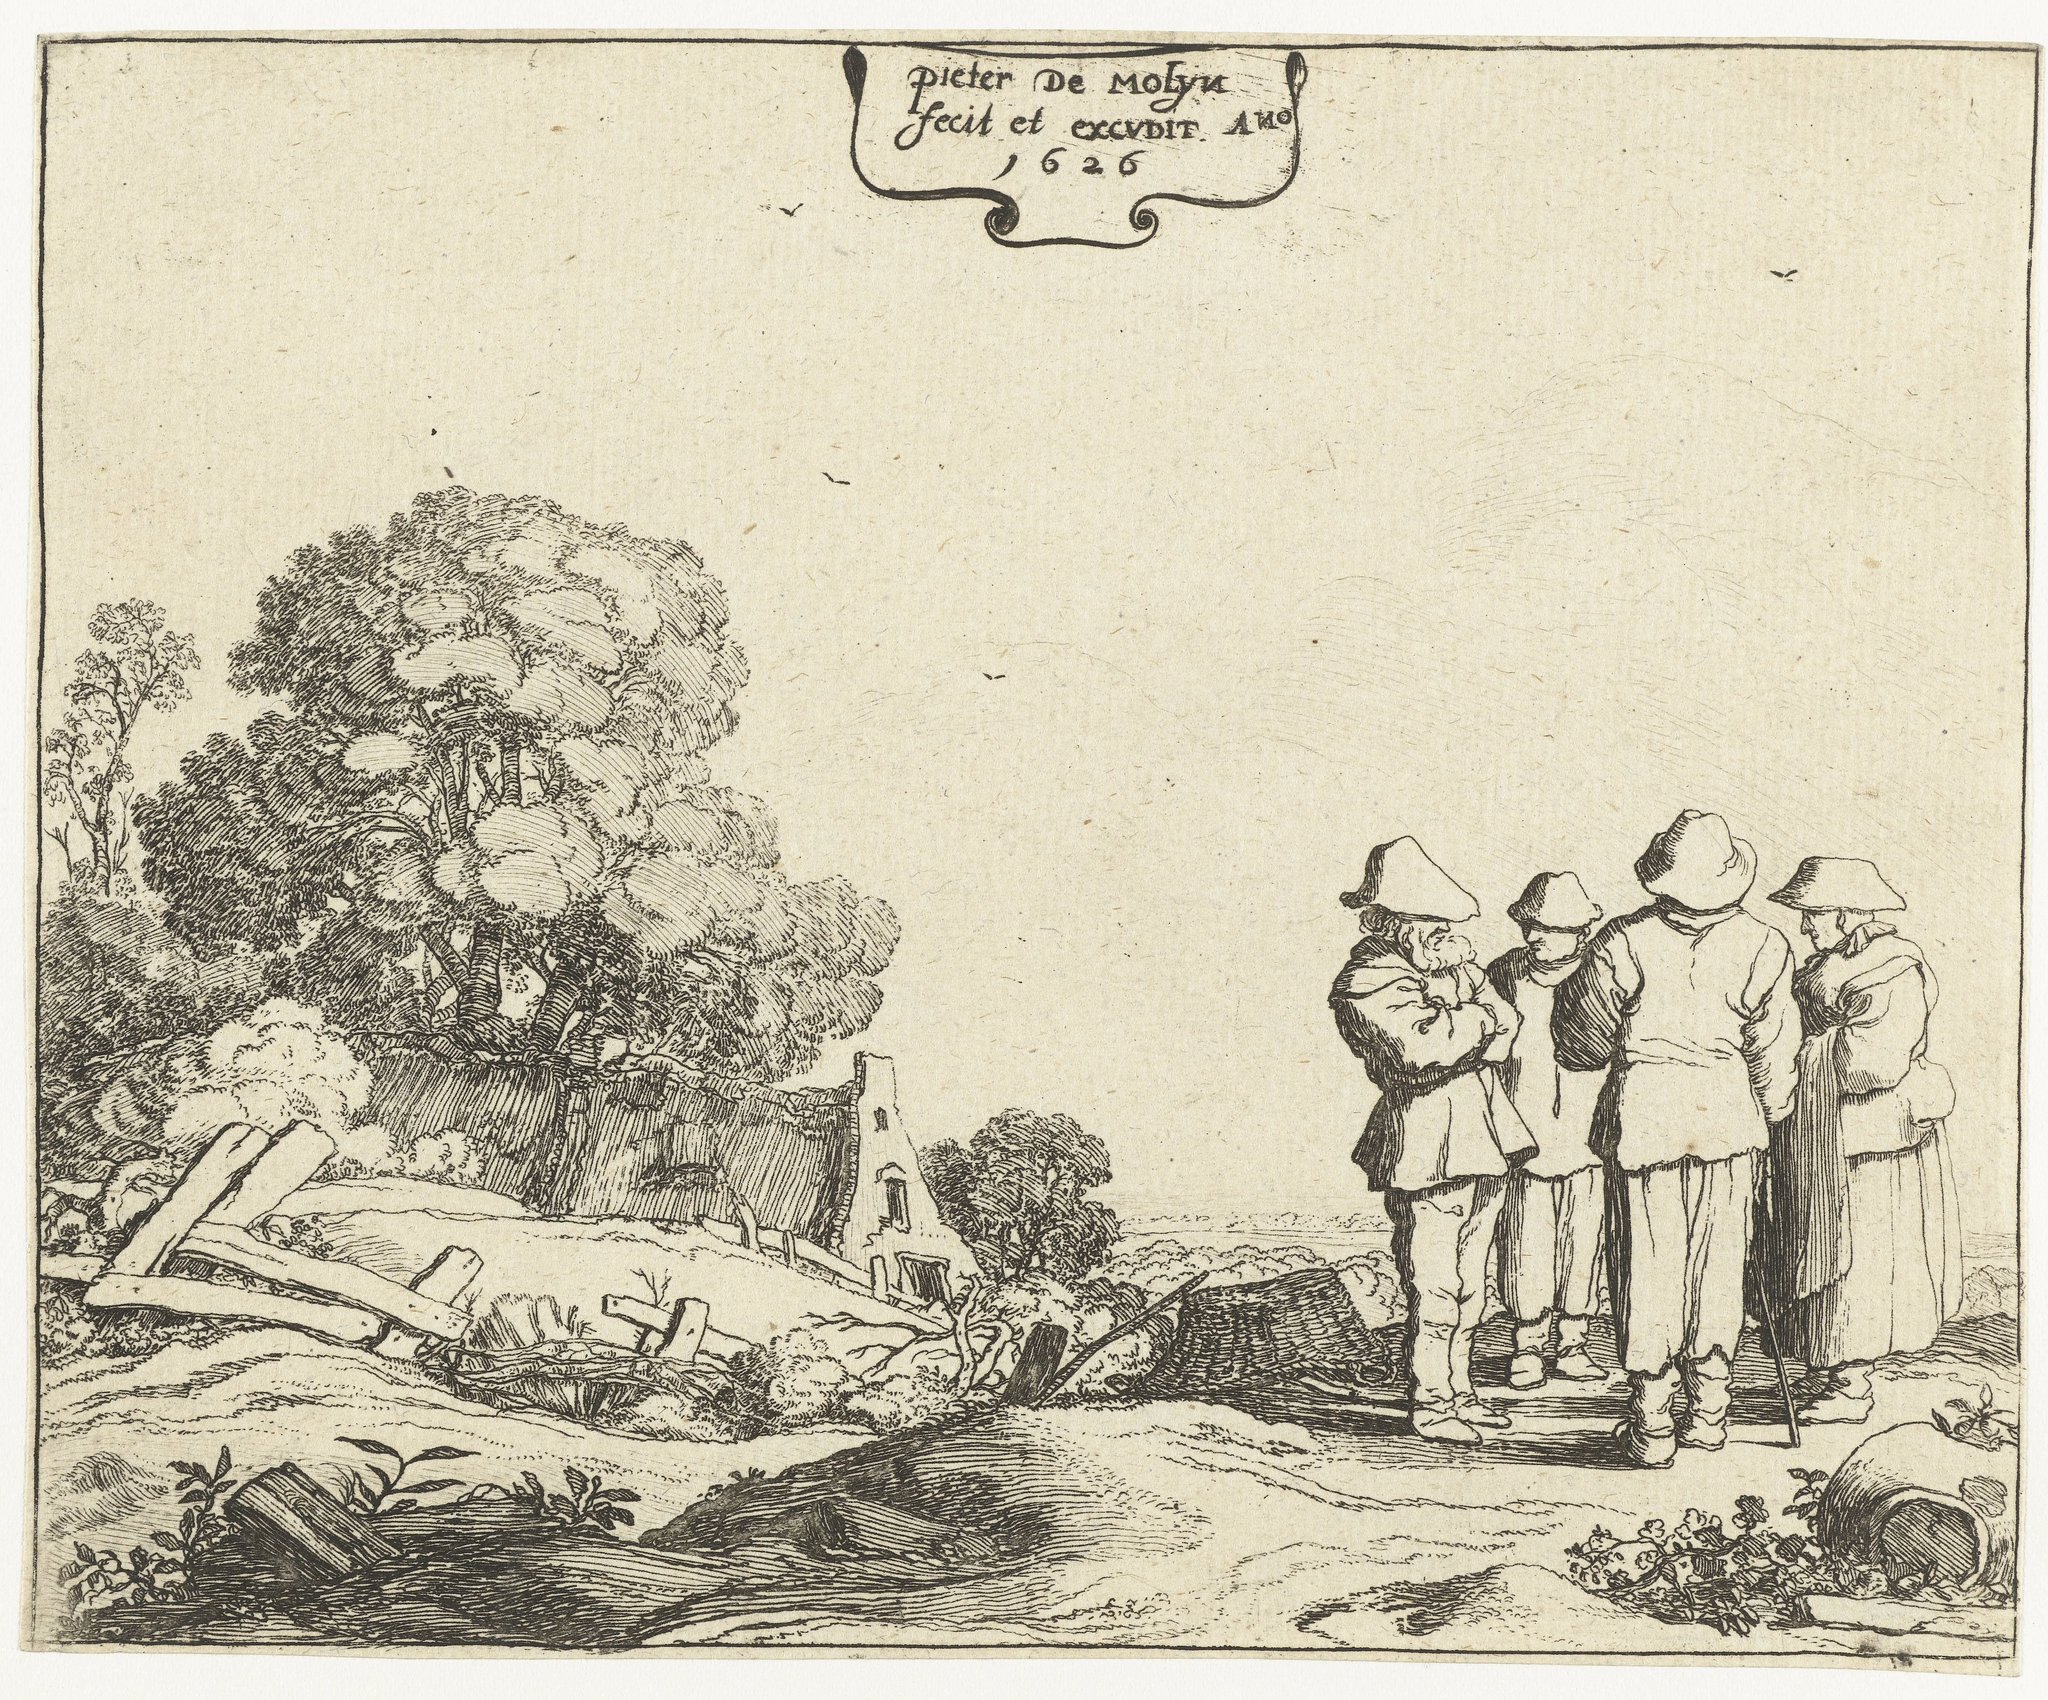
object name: print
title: Landschap met drie boeren en een boerin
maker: pieter de molijn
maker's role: draughtsman, painter, print maker, publisher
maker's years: 1595-1661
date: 1626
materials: paper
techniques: etching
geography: haarlem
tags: landscapes in the temperate zone, farmers, farm or solitary house in landscape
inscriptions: collector's mark: Lugt 2228a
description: In een landelijke omgeving staan drie boeren en een boerin in de buurt van een huis te praten. Bovenin de voorstelling een tablet met het adres van de prentmaker. Deze prent is onderdeel van een serie van vier prenten van landschappen met figuren.